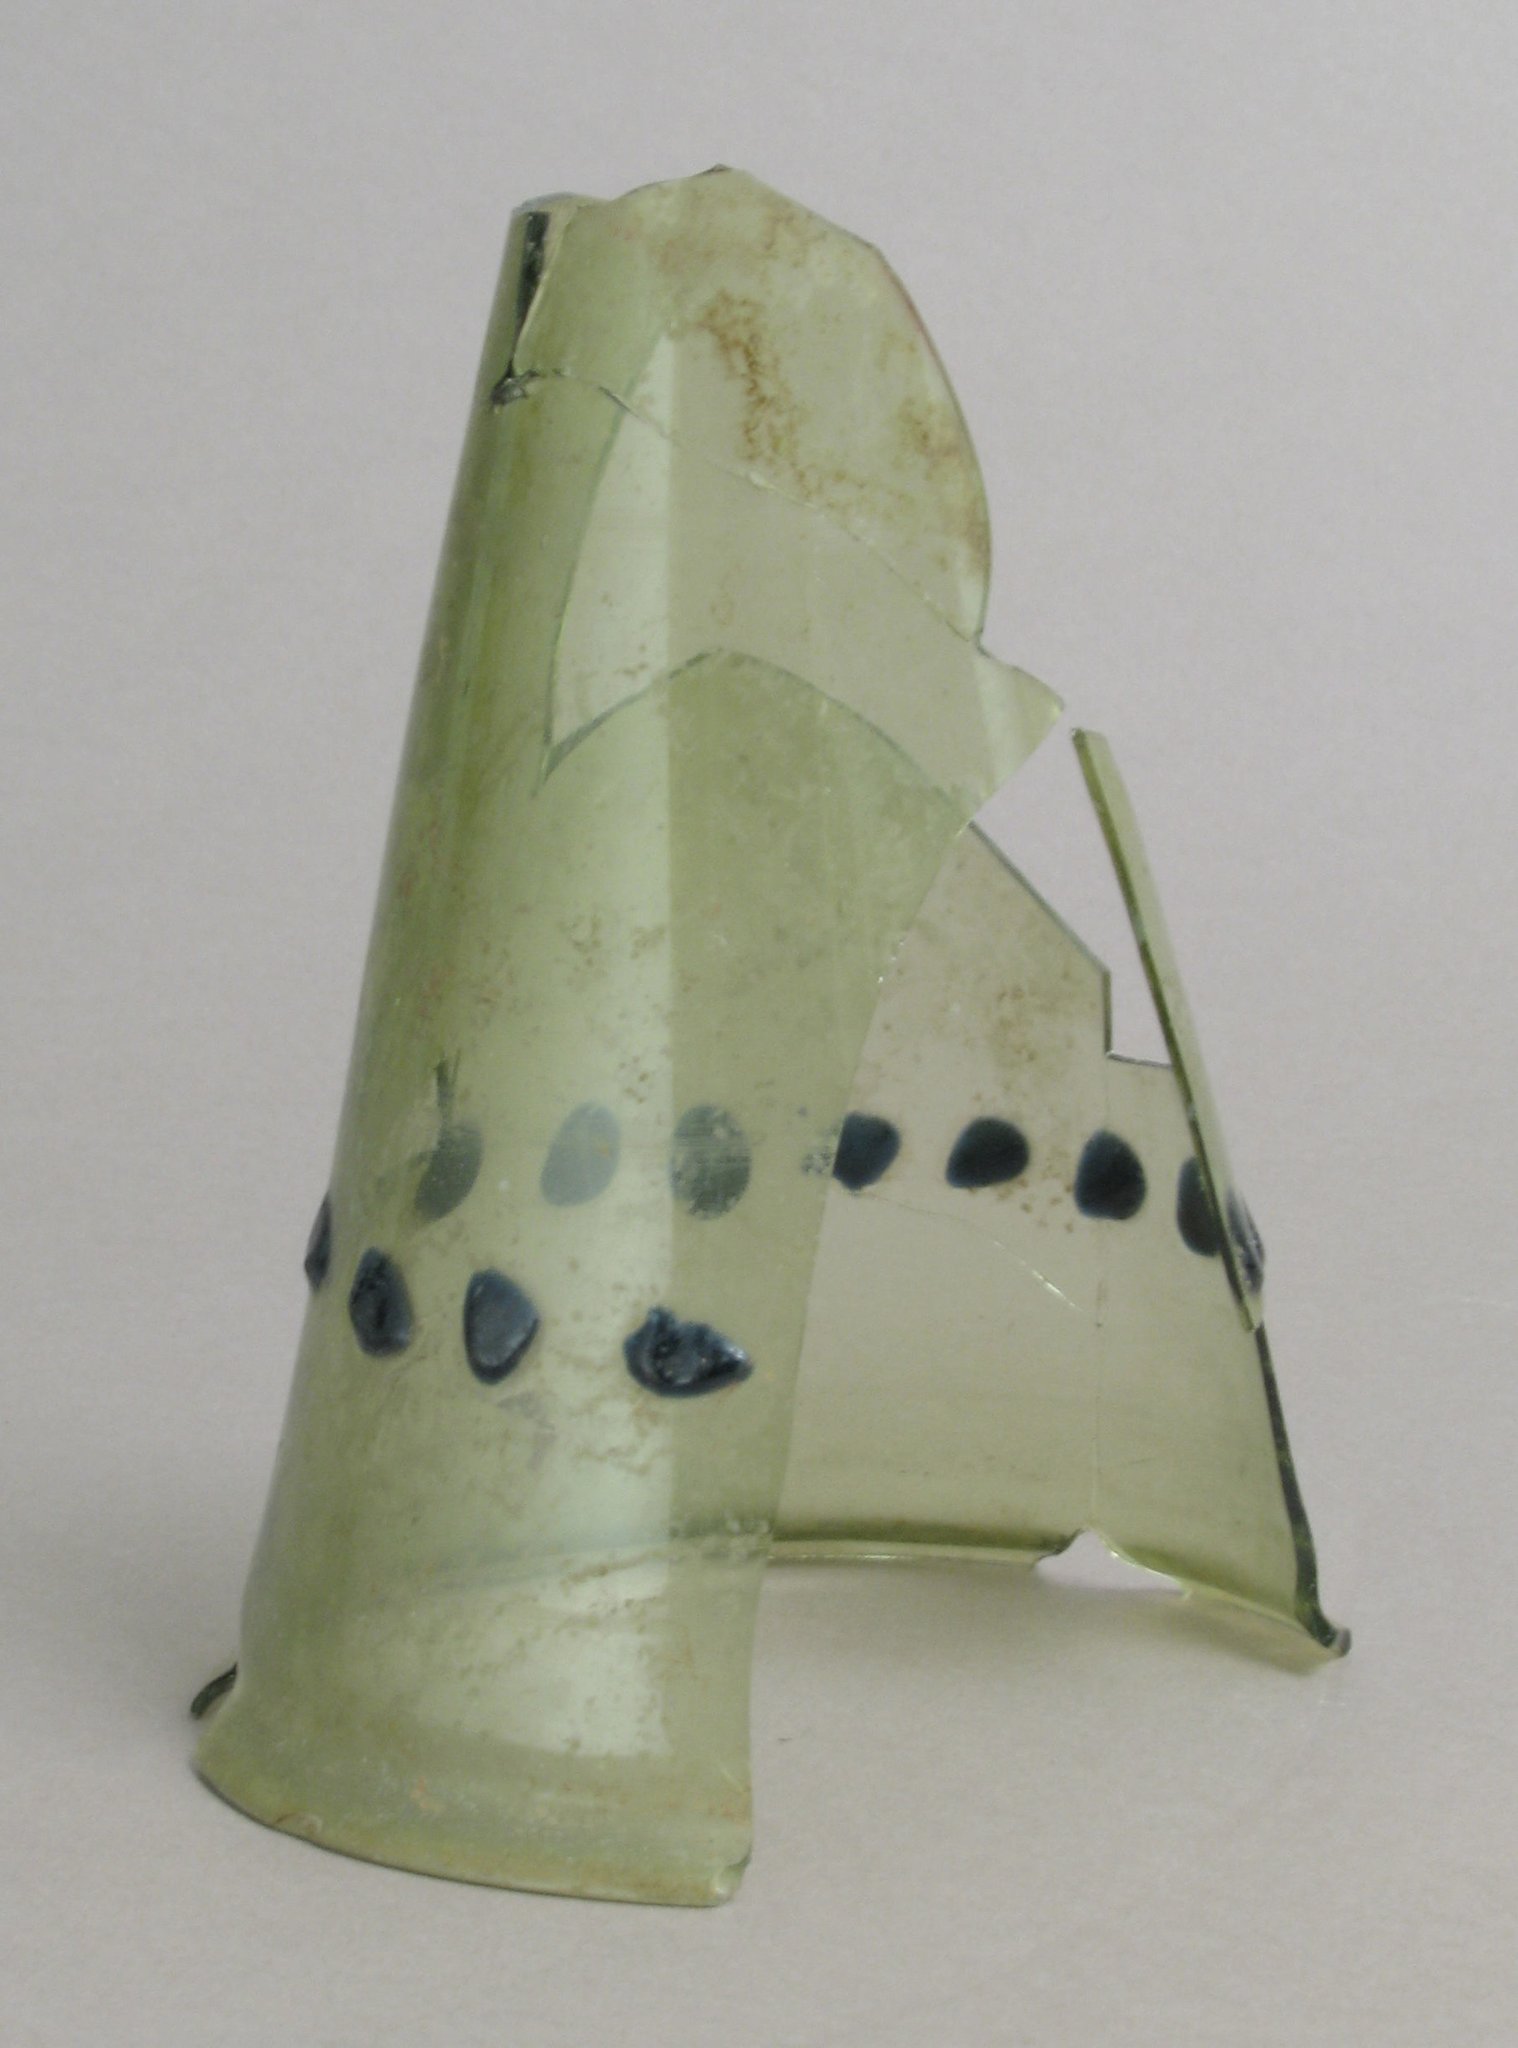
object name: fragment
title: Vessel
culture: coptic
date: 301-433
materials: glass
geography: egypt